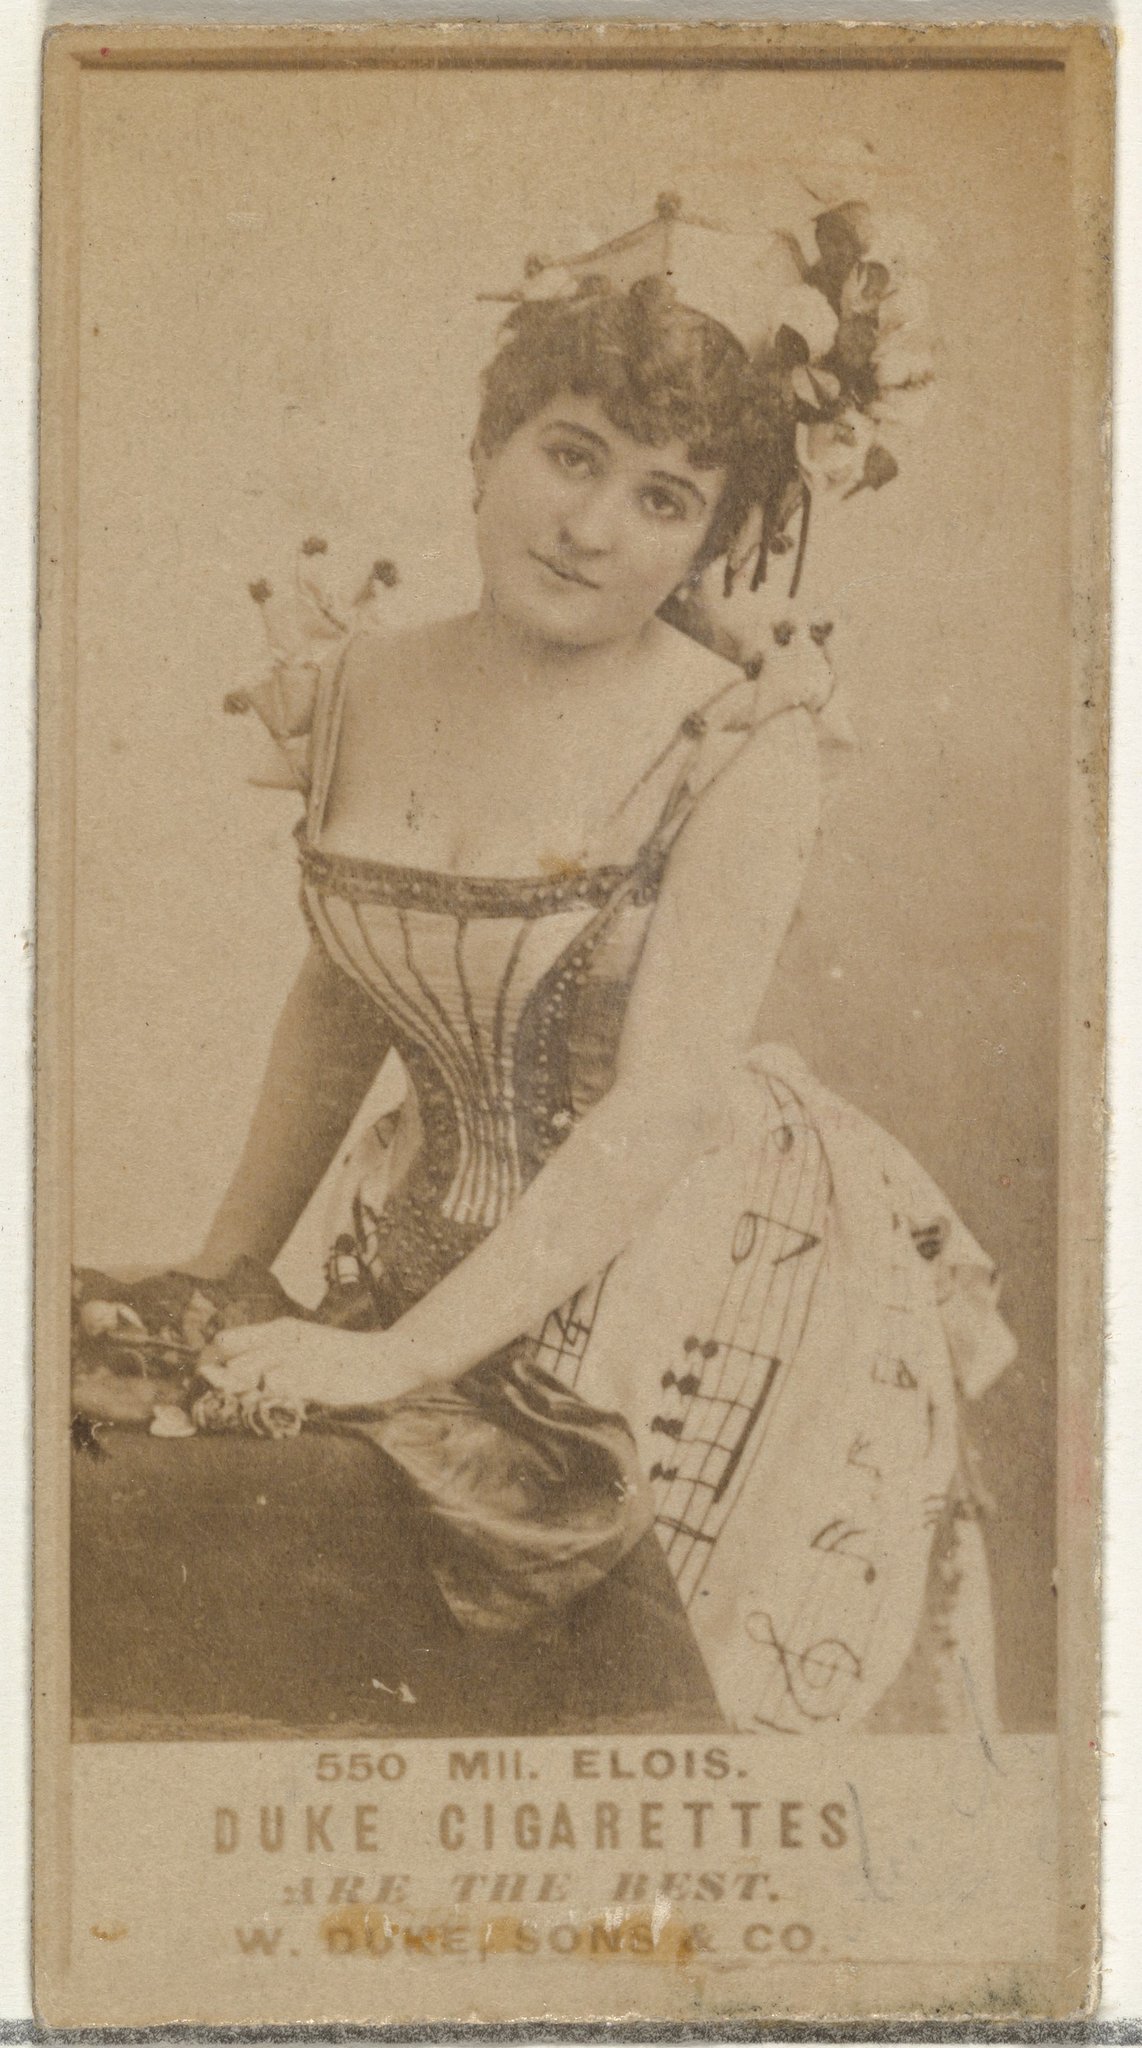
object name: photograph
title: Card Number 550, Mlle. Elois, from the Actors and Actresses series (N145-7) issued by Duke Sons & Co. to promote Duke Cigarettes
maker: w. duke, sons & co.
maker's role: publisher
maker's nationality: american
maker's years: 1870-1920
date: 1880-1889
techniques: albumen silver print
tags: portraits,women,actresses